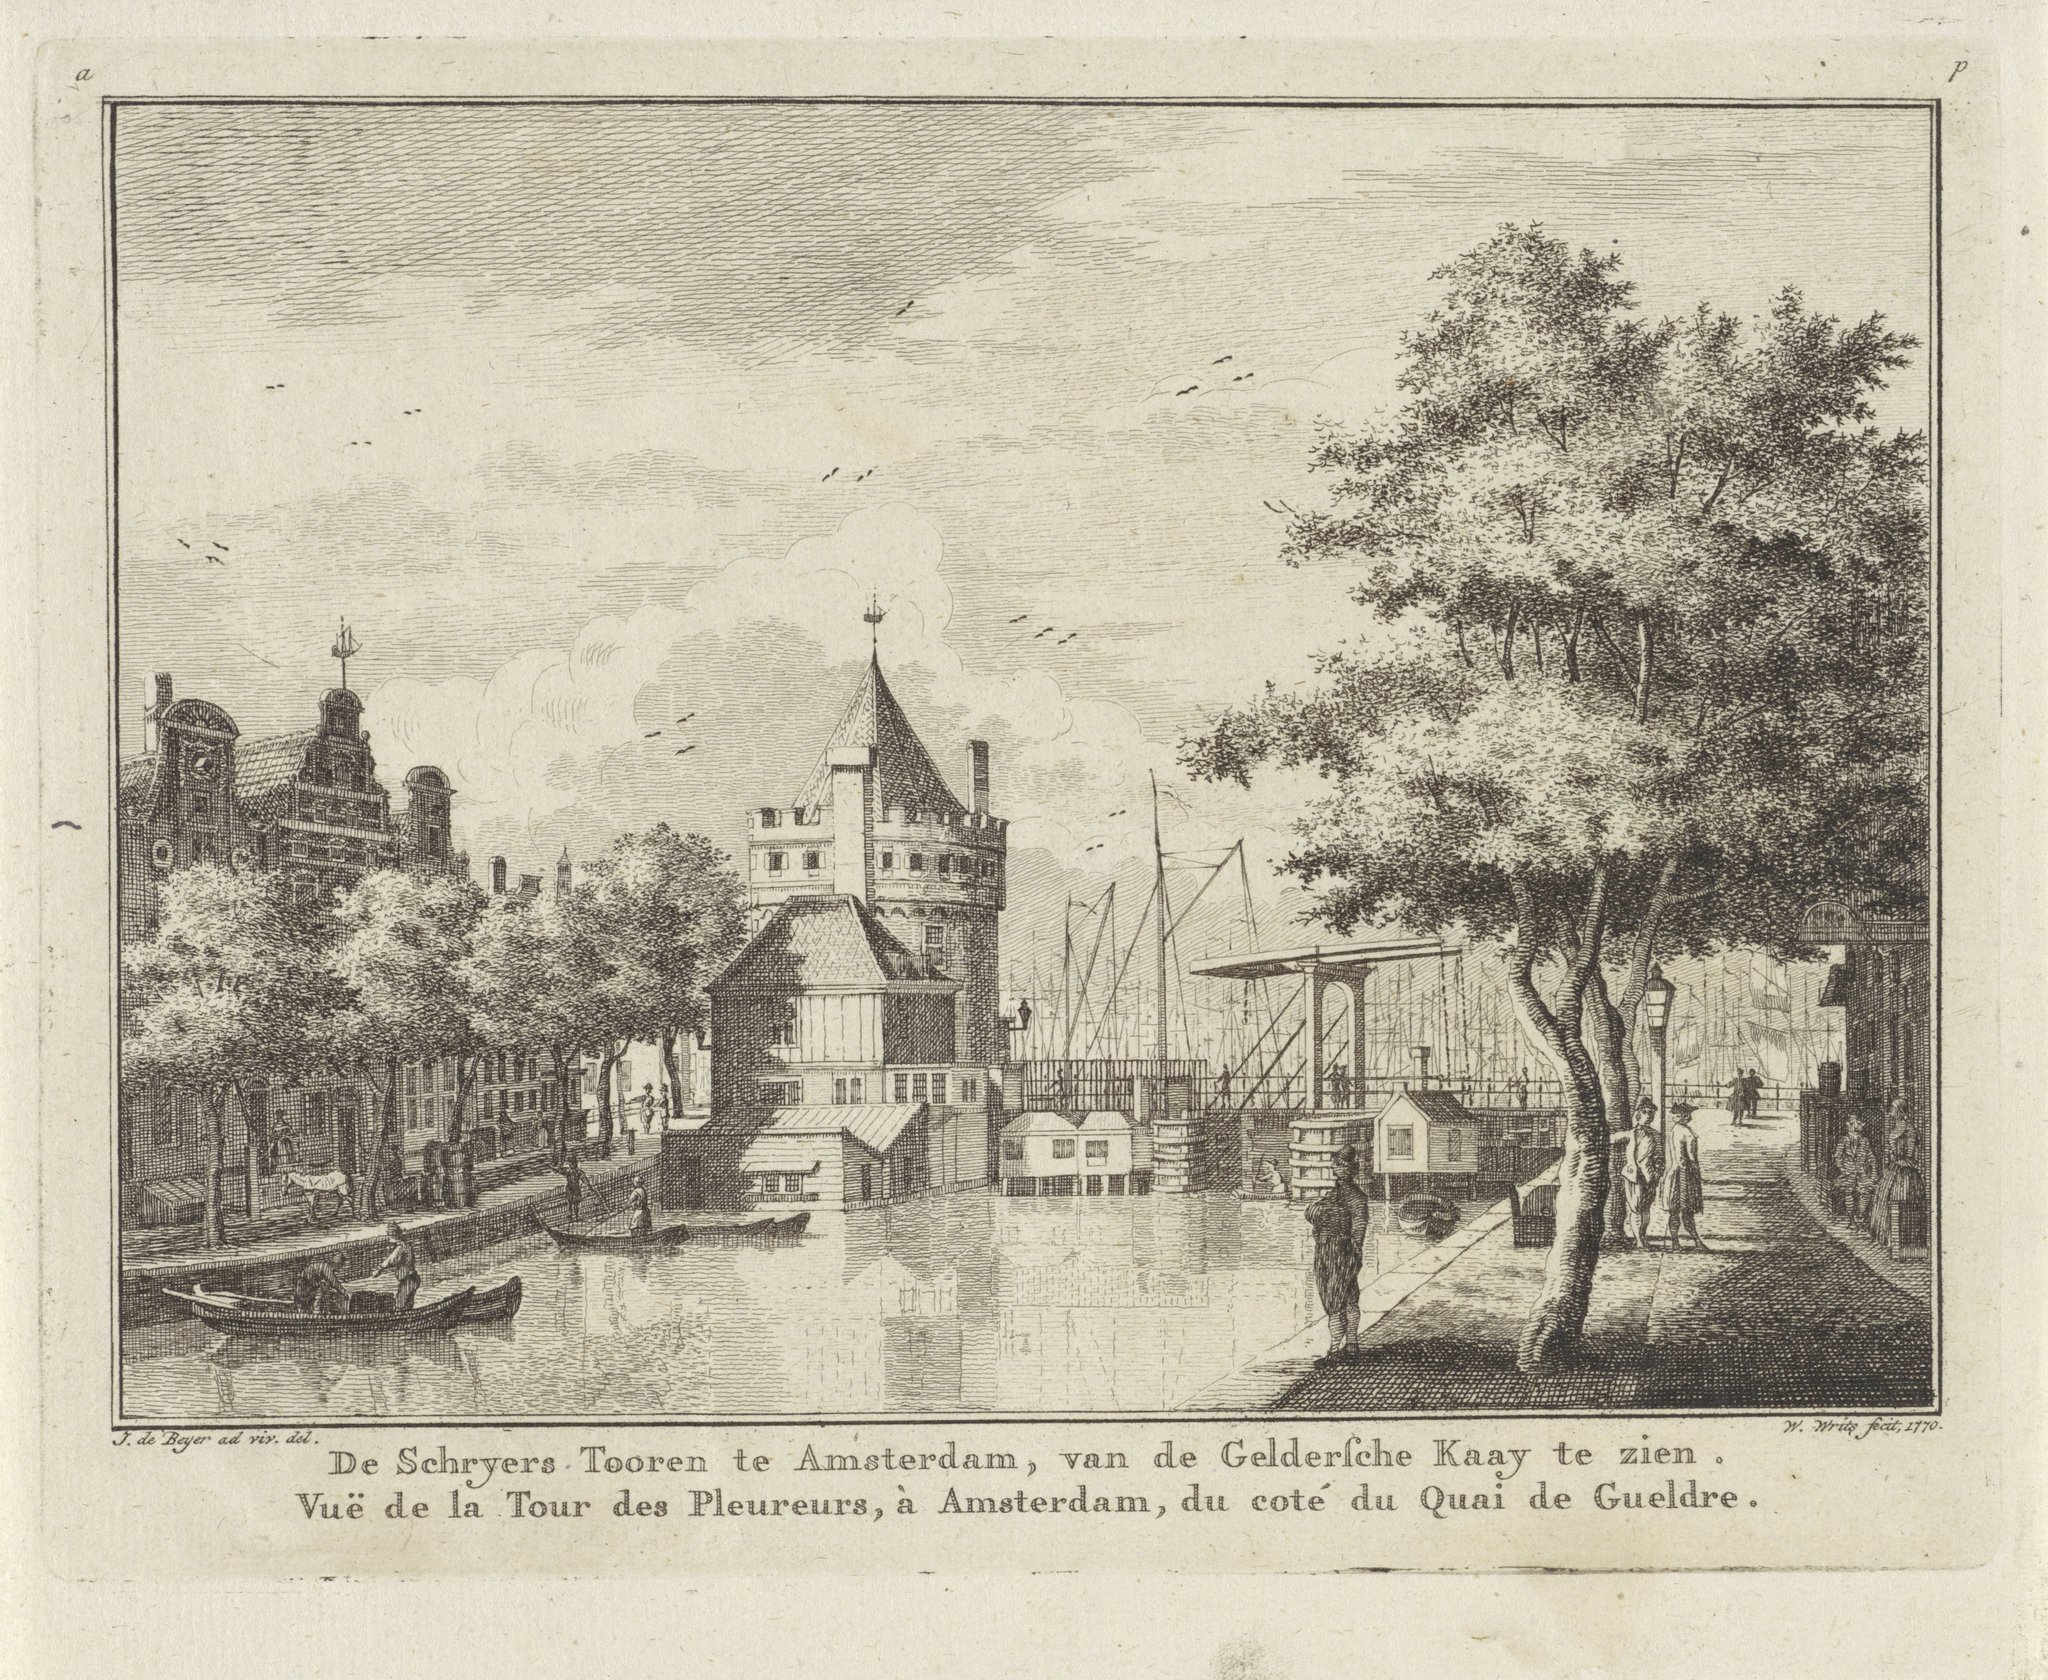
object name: print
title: Gezicht op de Schreierstoren vanaf de Geldersekade te Amsterdam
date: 1770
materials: paper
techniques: etching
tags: schreierstoren, geldersekade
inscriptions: collector's mark: Lugt 2228